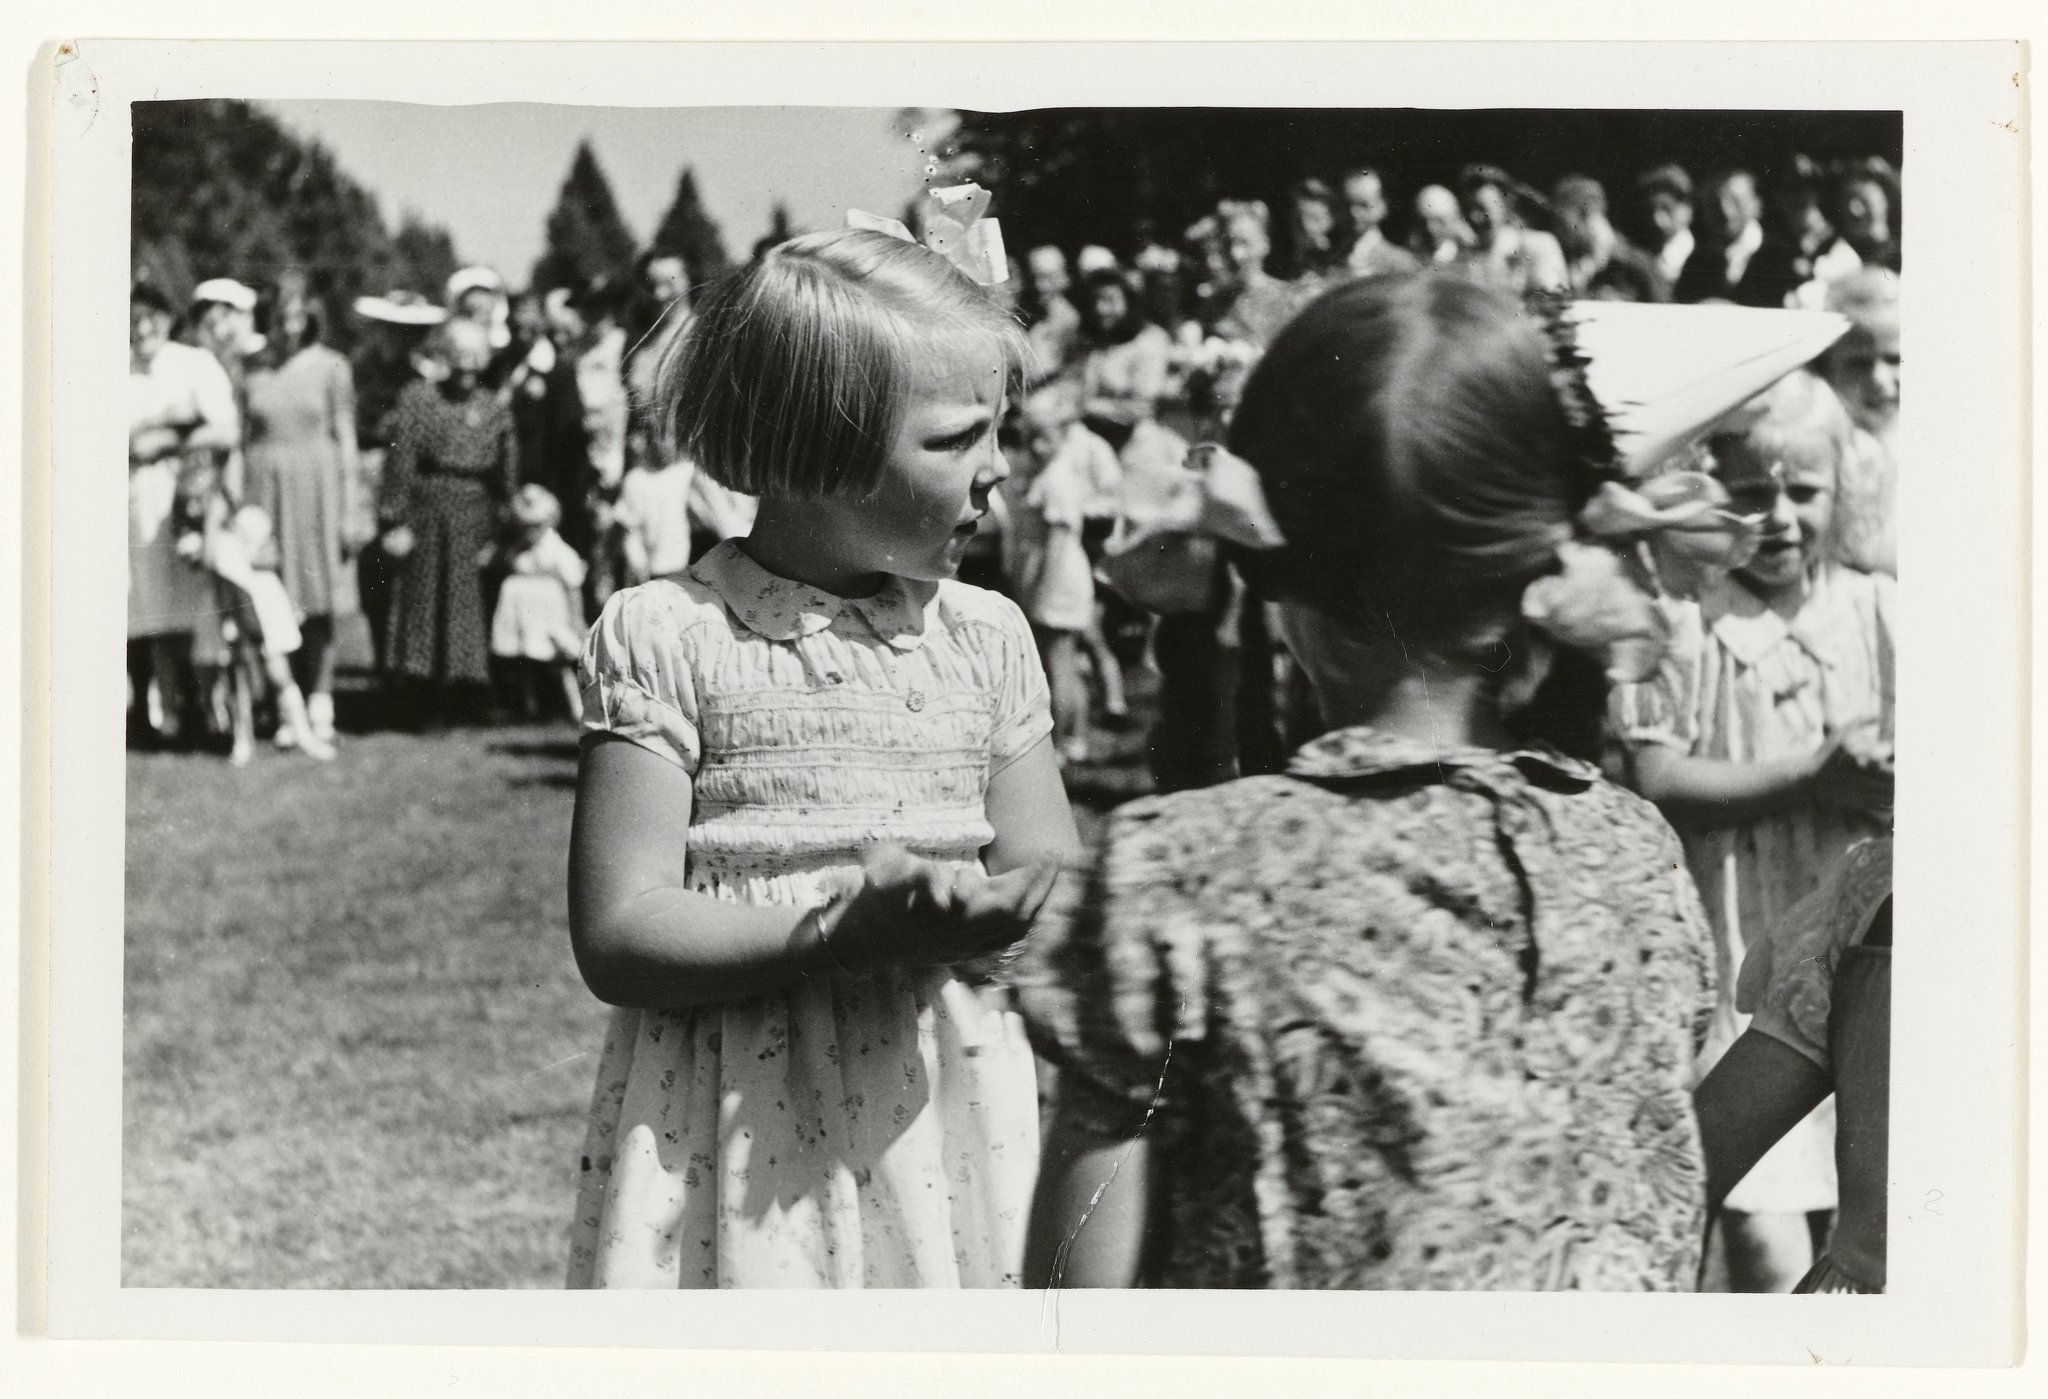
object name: photograph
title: Feest ter ere terugkeer prinsesjes in Nederland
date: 1945-1946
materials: photographic support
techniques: photography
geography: netherlands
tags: beatrix (koningin der nederlanden), the hague, juliana of the netherlands, netherlands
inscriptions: inscription, stamp: ‘COPYRIGHT / 'ANEFO' / ALGEMEEN NEDERLANDSCH FOTOBUREAU’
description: Prinses Beatrix temidden van andere kinderen tijdens een feest ter ere van hun terugkeer naar Nederland